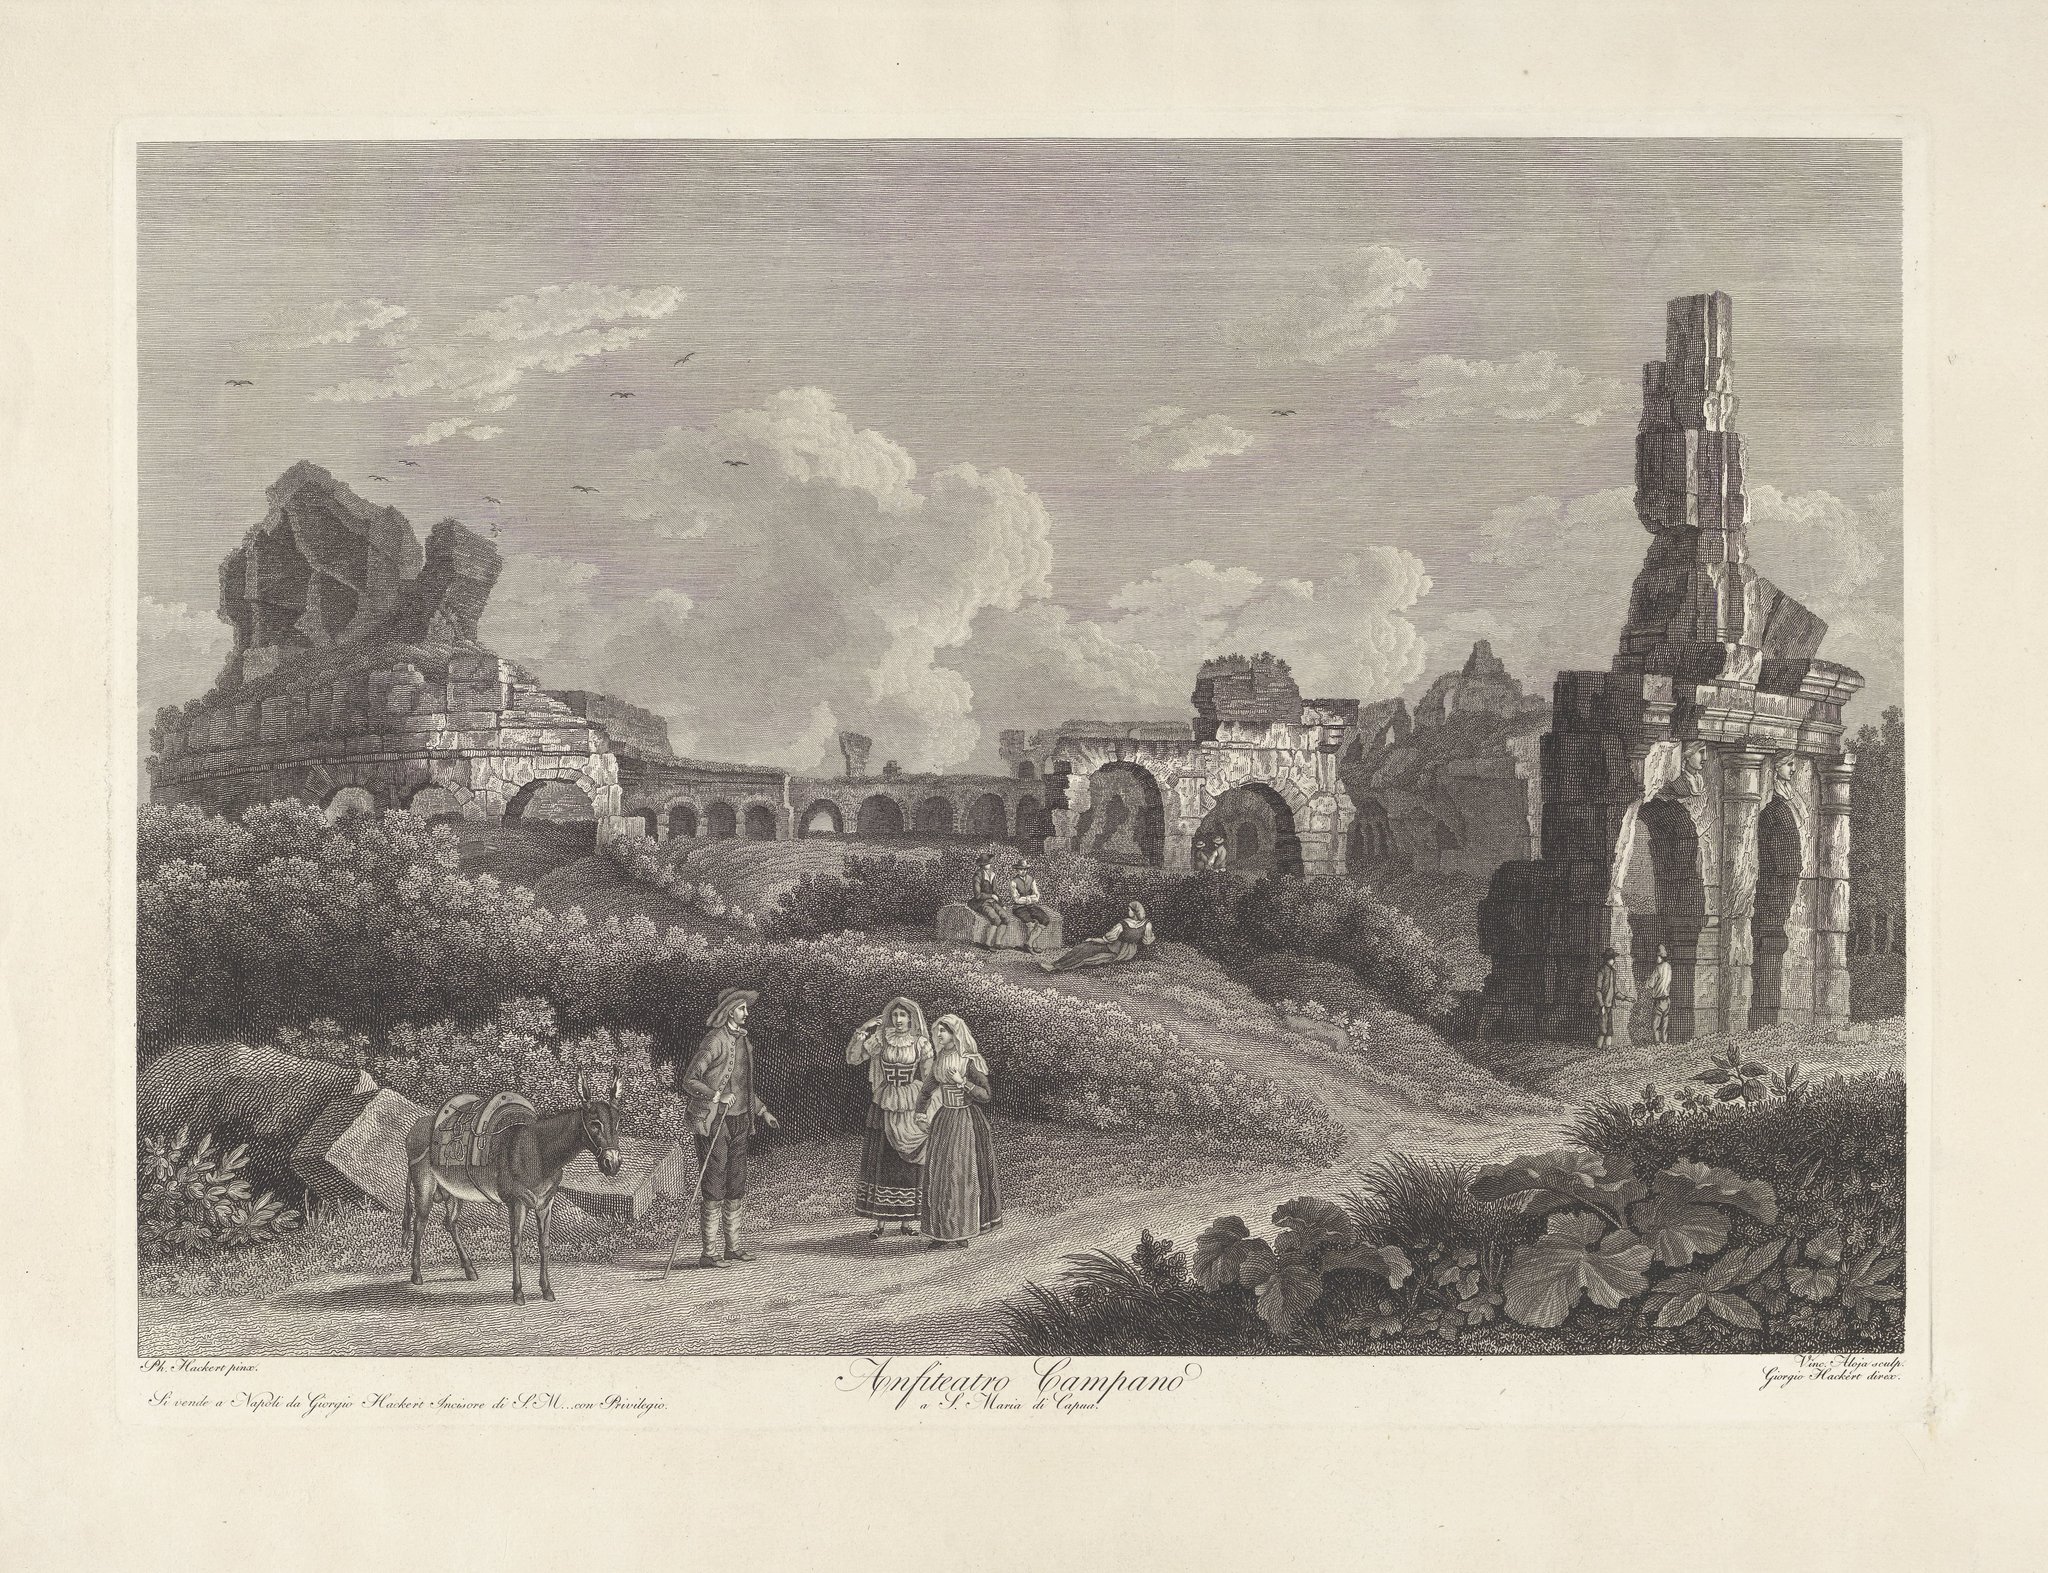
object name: print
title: Anfiteatro Campano a S. Maria di Capua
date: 1781-1820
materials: paper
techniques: etching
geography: italy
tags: ruin of a building ~ architecture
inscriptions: collector's mark: Lugt 2228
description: Gezicht op de ruïnes van het amfitheater van Capua bij de stad Santa Maria Capua Vetere. Figuren rustend tussen de ruïnes. Op de voorgrond twee vrouwen, een man en een ezel. Titel in ondermarge.